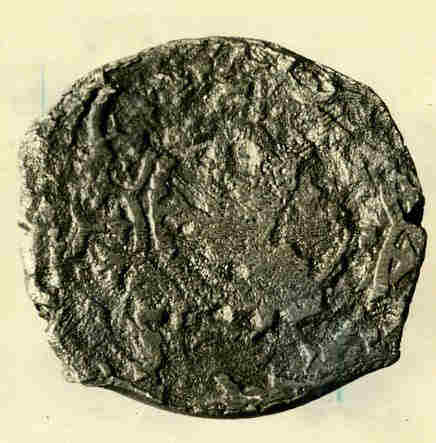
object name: coin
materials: copper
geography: iran